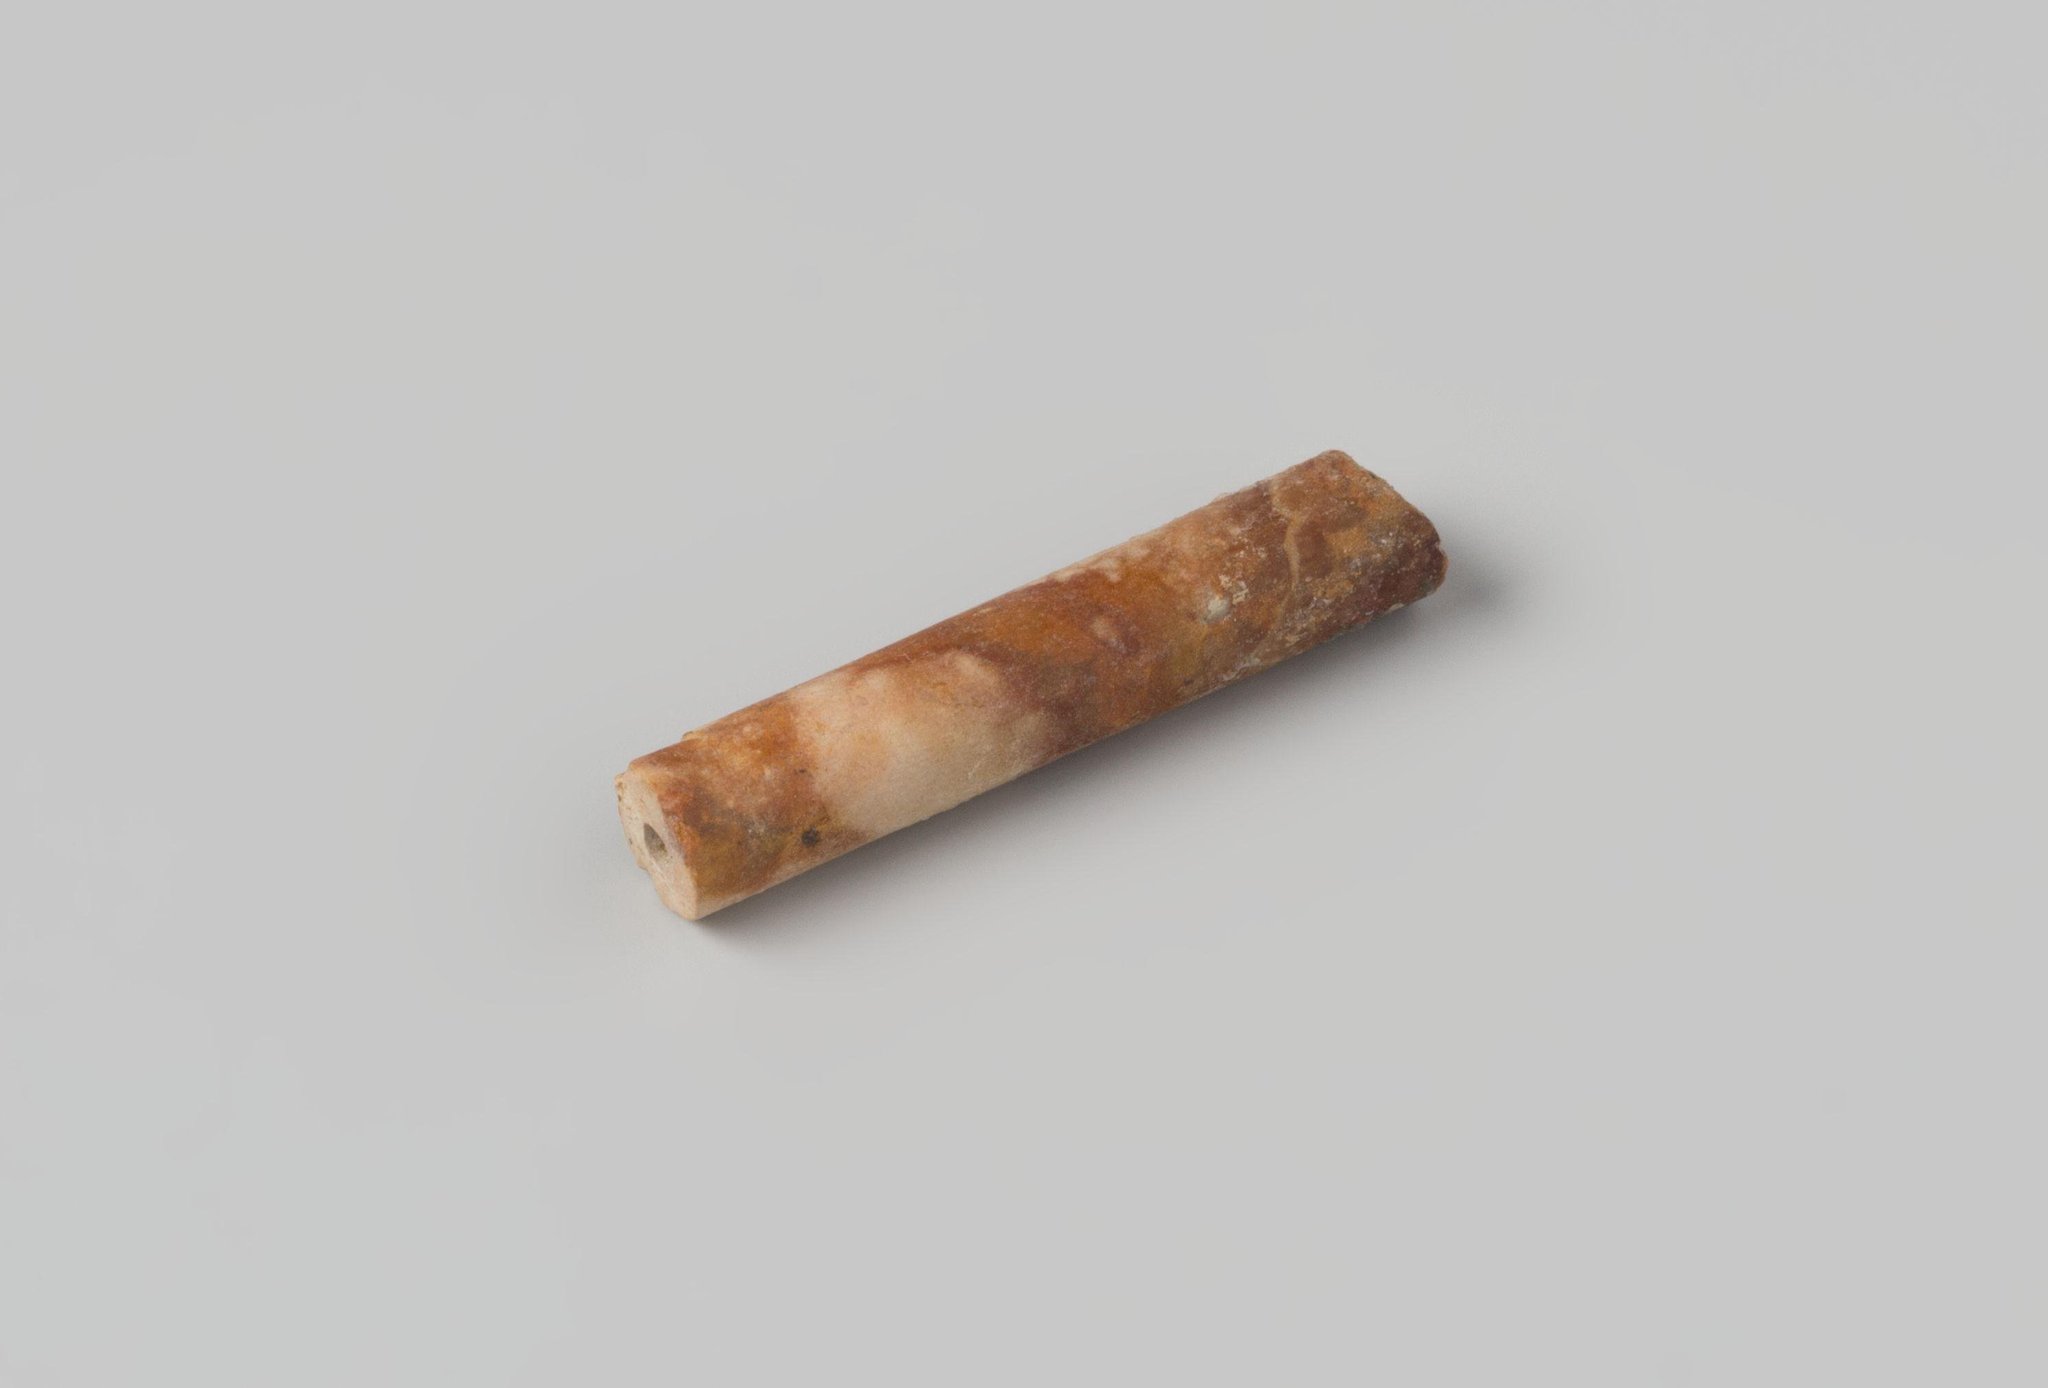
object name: pipe stem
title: Fragment pijpensteel uit het wrak van de Oost-Indiëvaarder Hollandia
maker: Anonymous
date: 1700-1743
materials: clay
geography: netherlands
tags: verenigde oostindische compagnie, hollandia (schip), annet